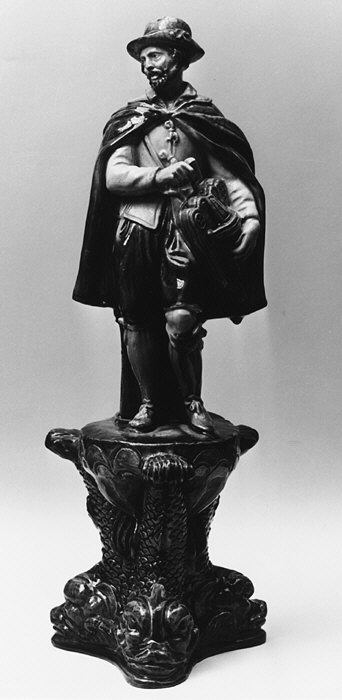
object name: statuette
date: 1601-1633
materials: earthenware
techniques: glazing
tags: men